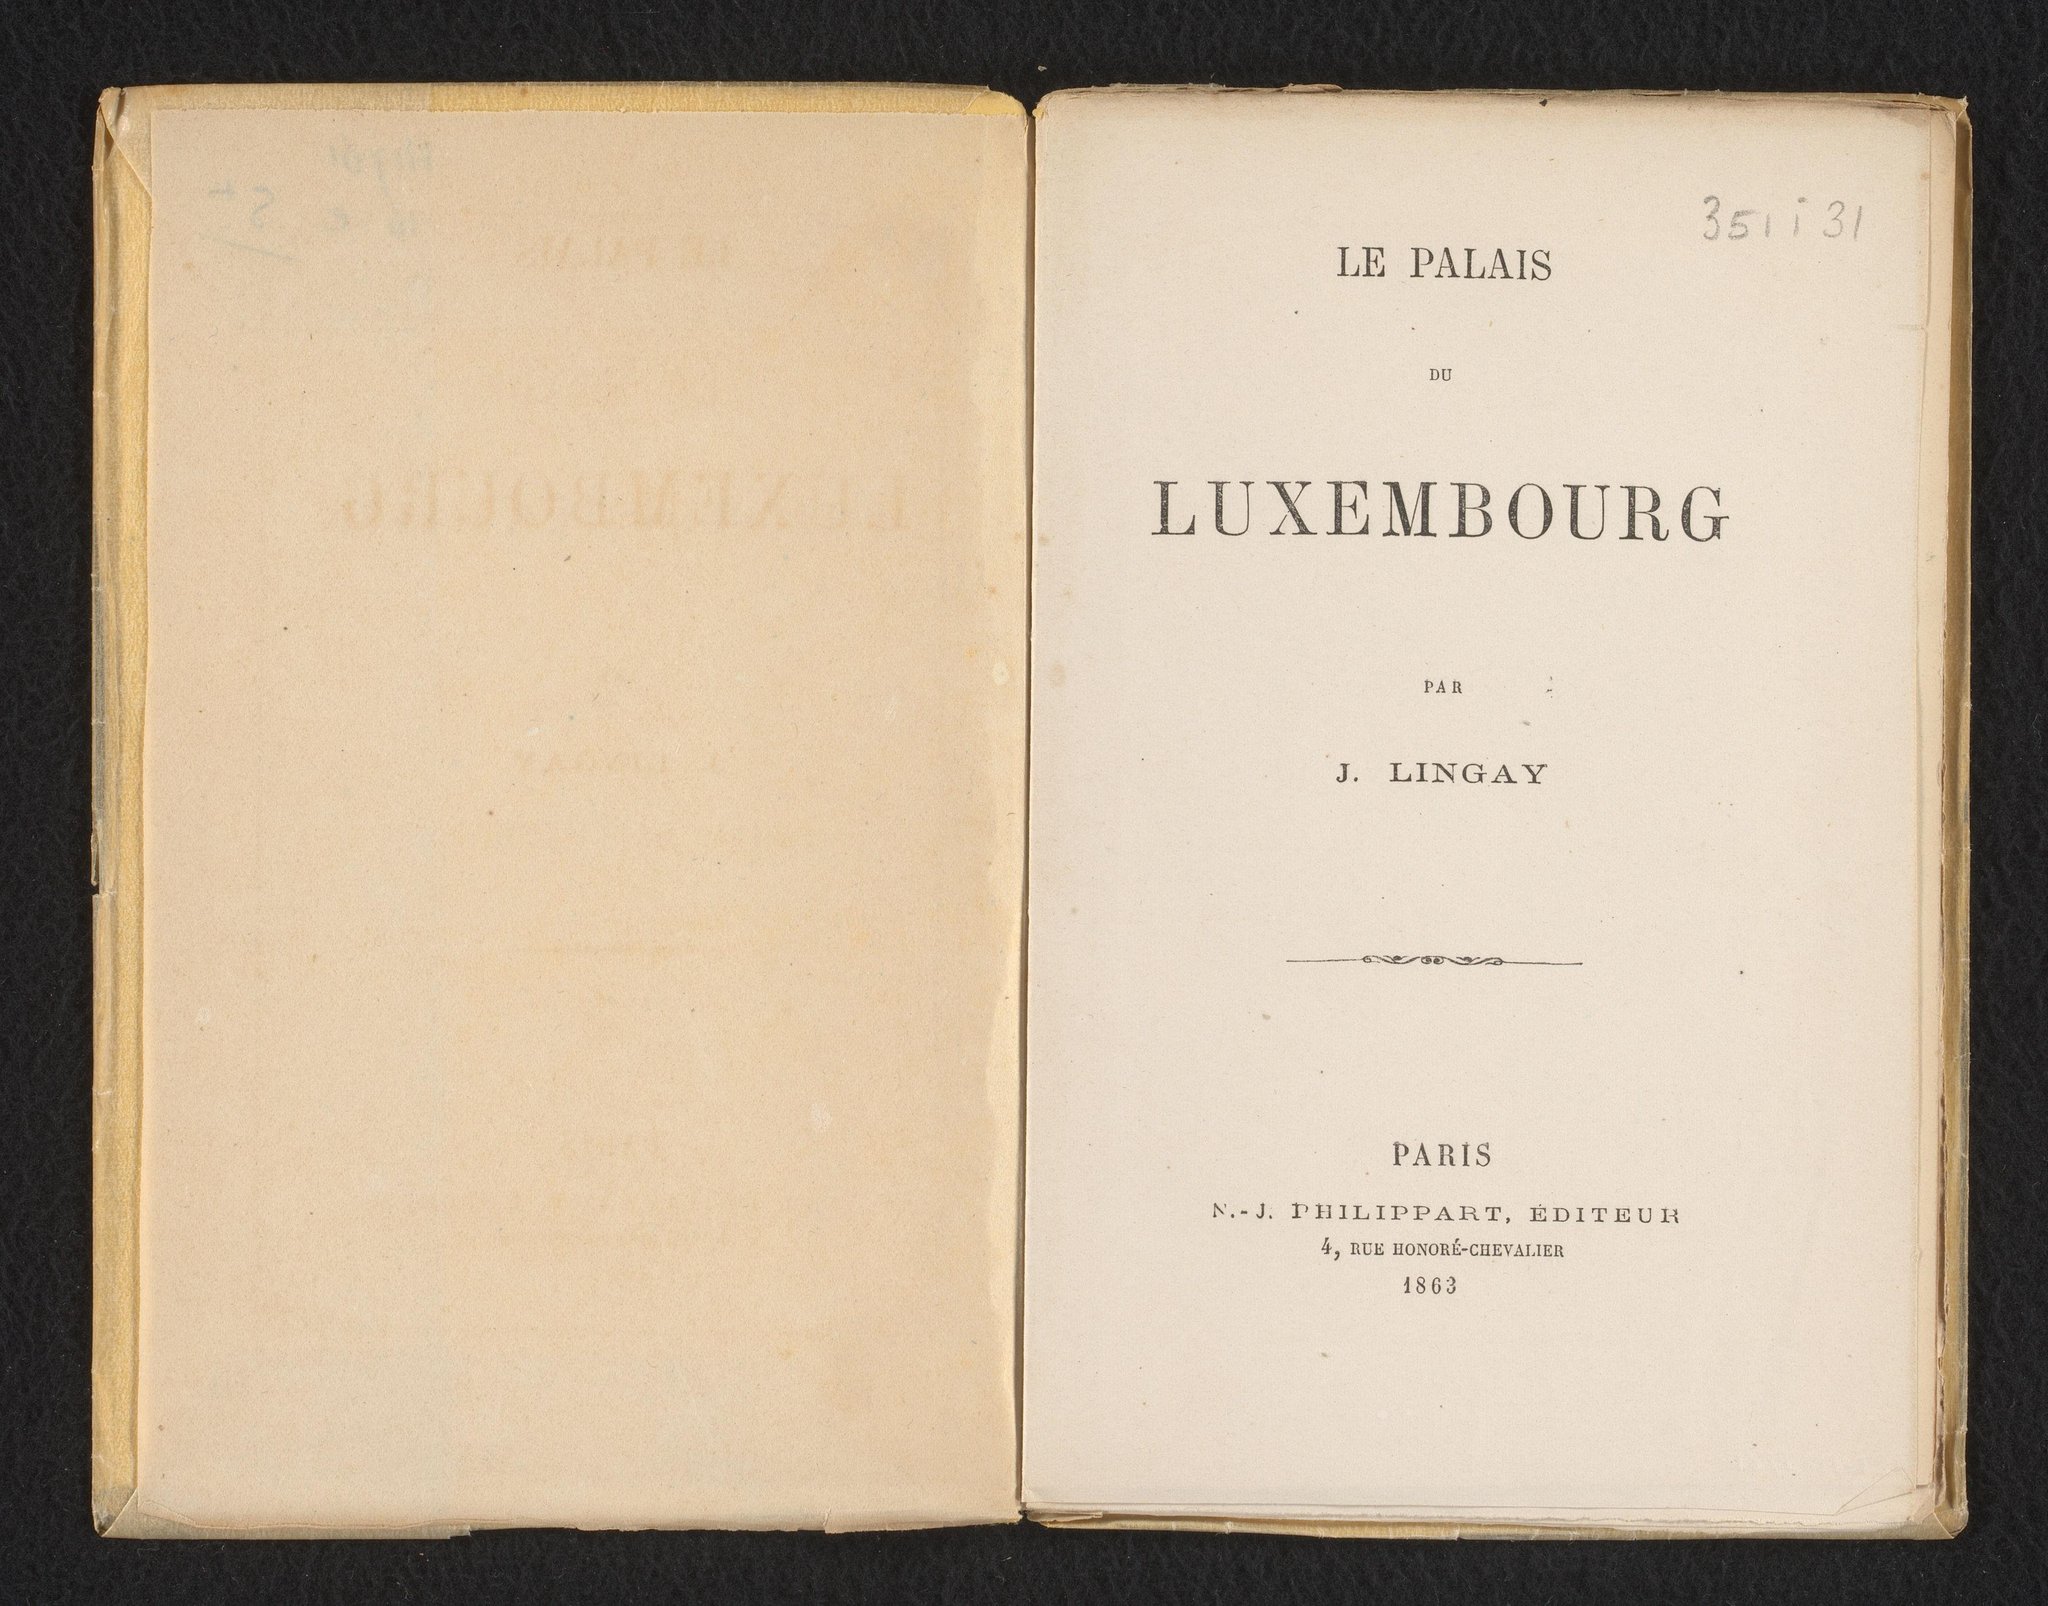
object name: book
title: Le Palais du Luxembourg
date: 1863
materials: paper, cardboard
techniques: albumen print, letterpress printing, lithograph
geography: paris